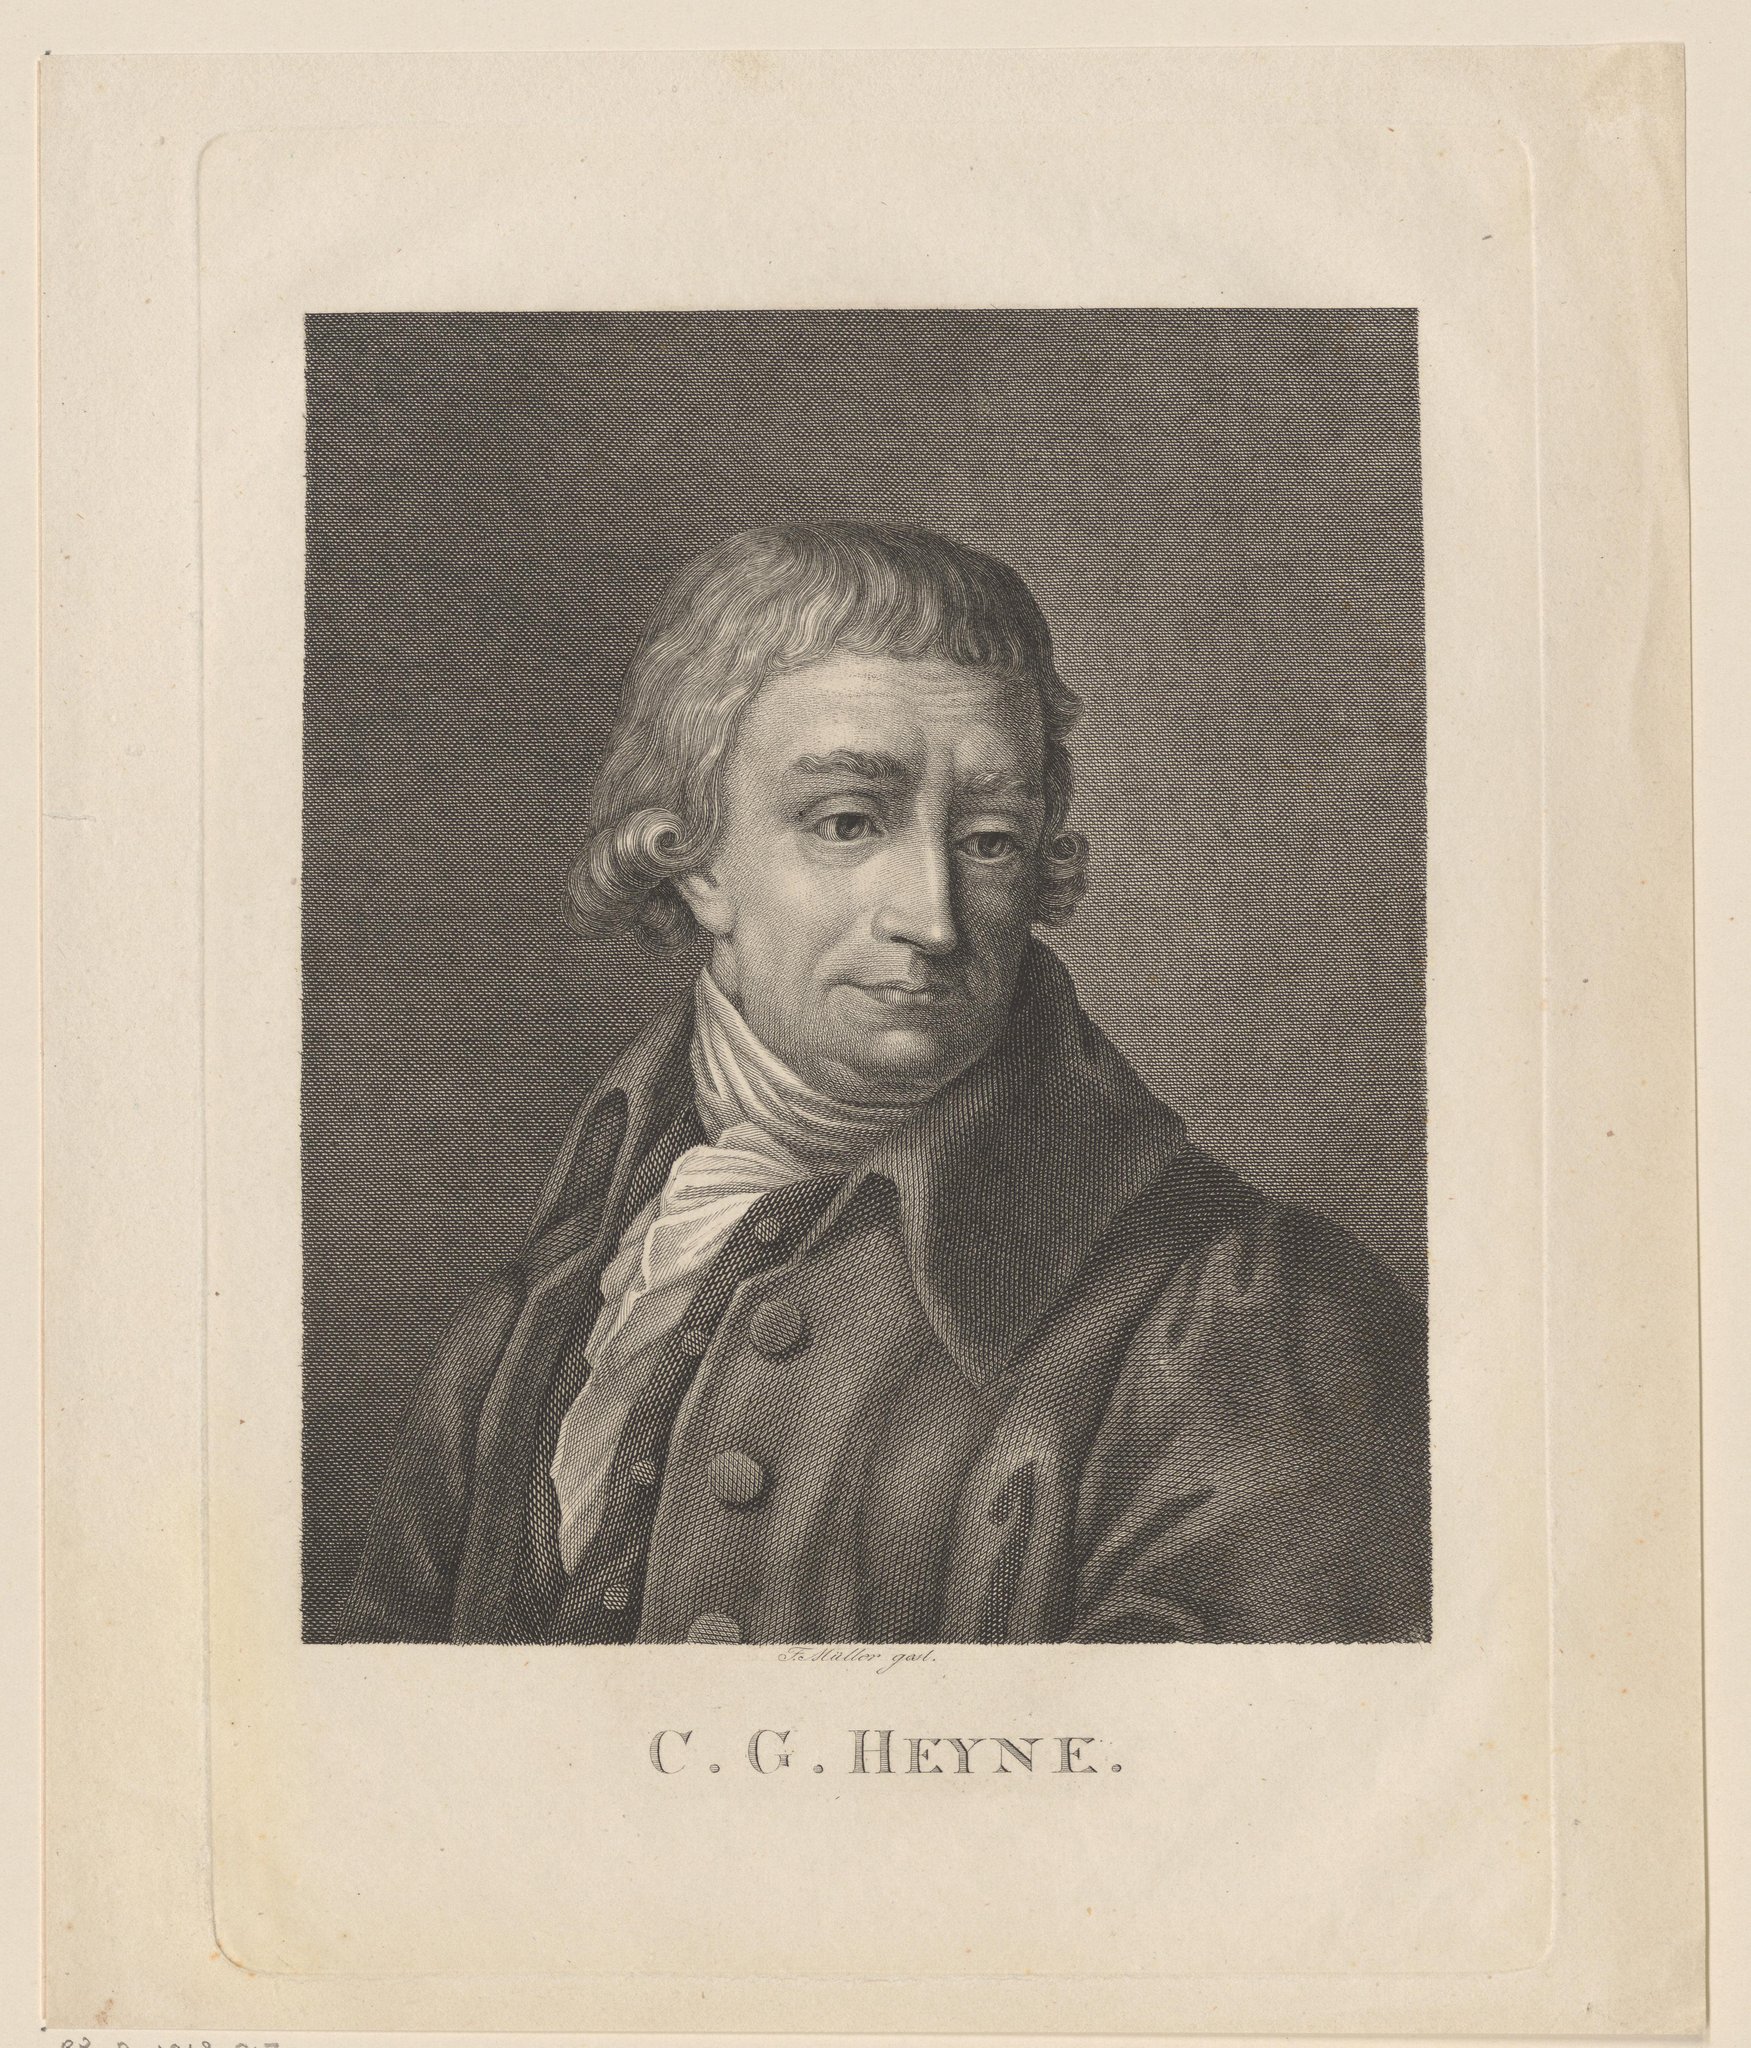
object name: print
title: Portret van Christian Gottlob Heyne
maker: f. müller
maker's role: draughtsman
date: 1775-1799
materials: paper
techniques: engraving, etching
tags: scholar, philosopher, historical persons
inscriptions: collector's mark: Lugt 2233